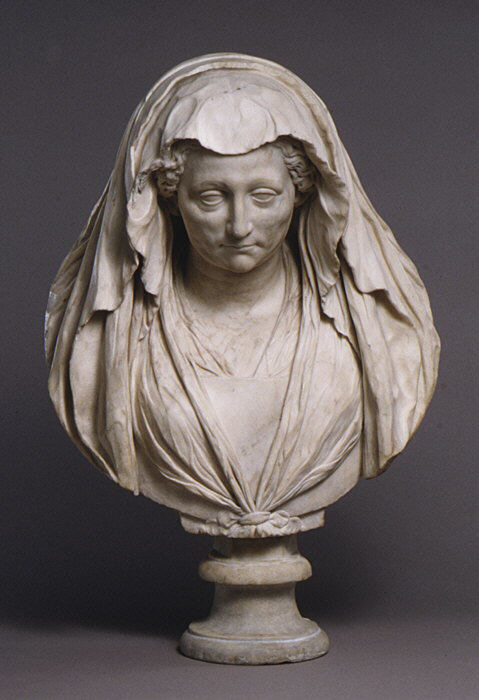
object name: bust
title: Luisa Deti (d. 1557)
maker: ippolito buzio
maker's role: artist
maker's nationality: italian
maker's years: 1562-1634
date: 1604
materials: marble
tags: portraits,women